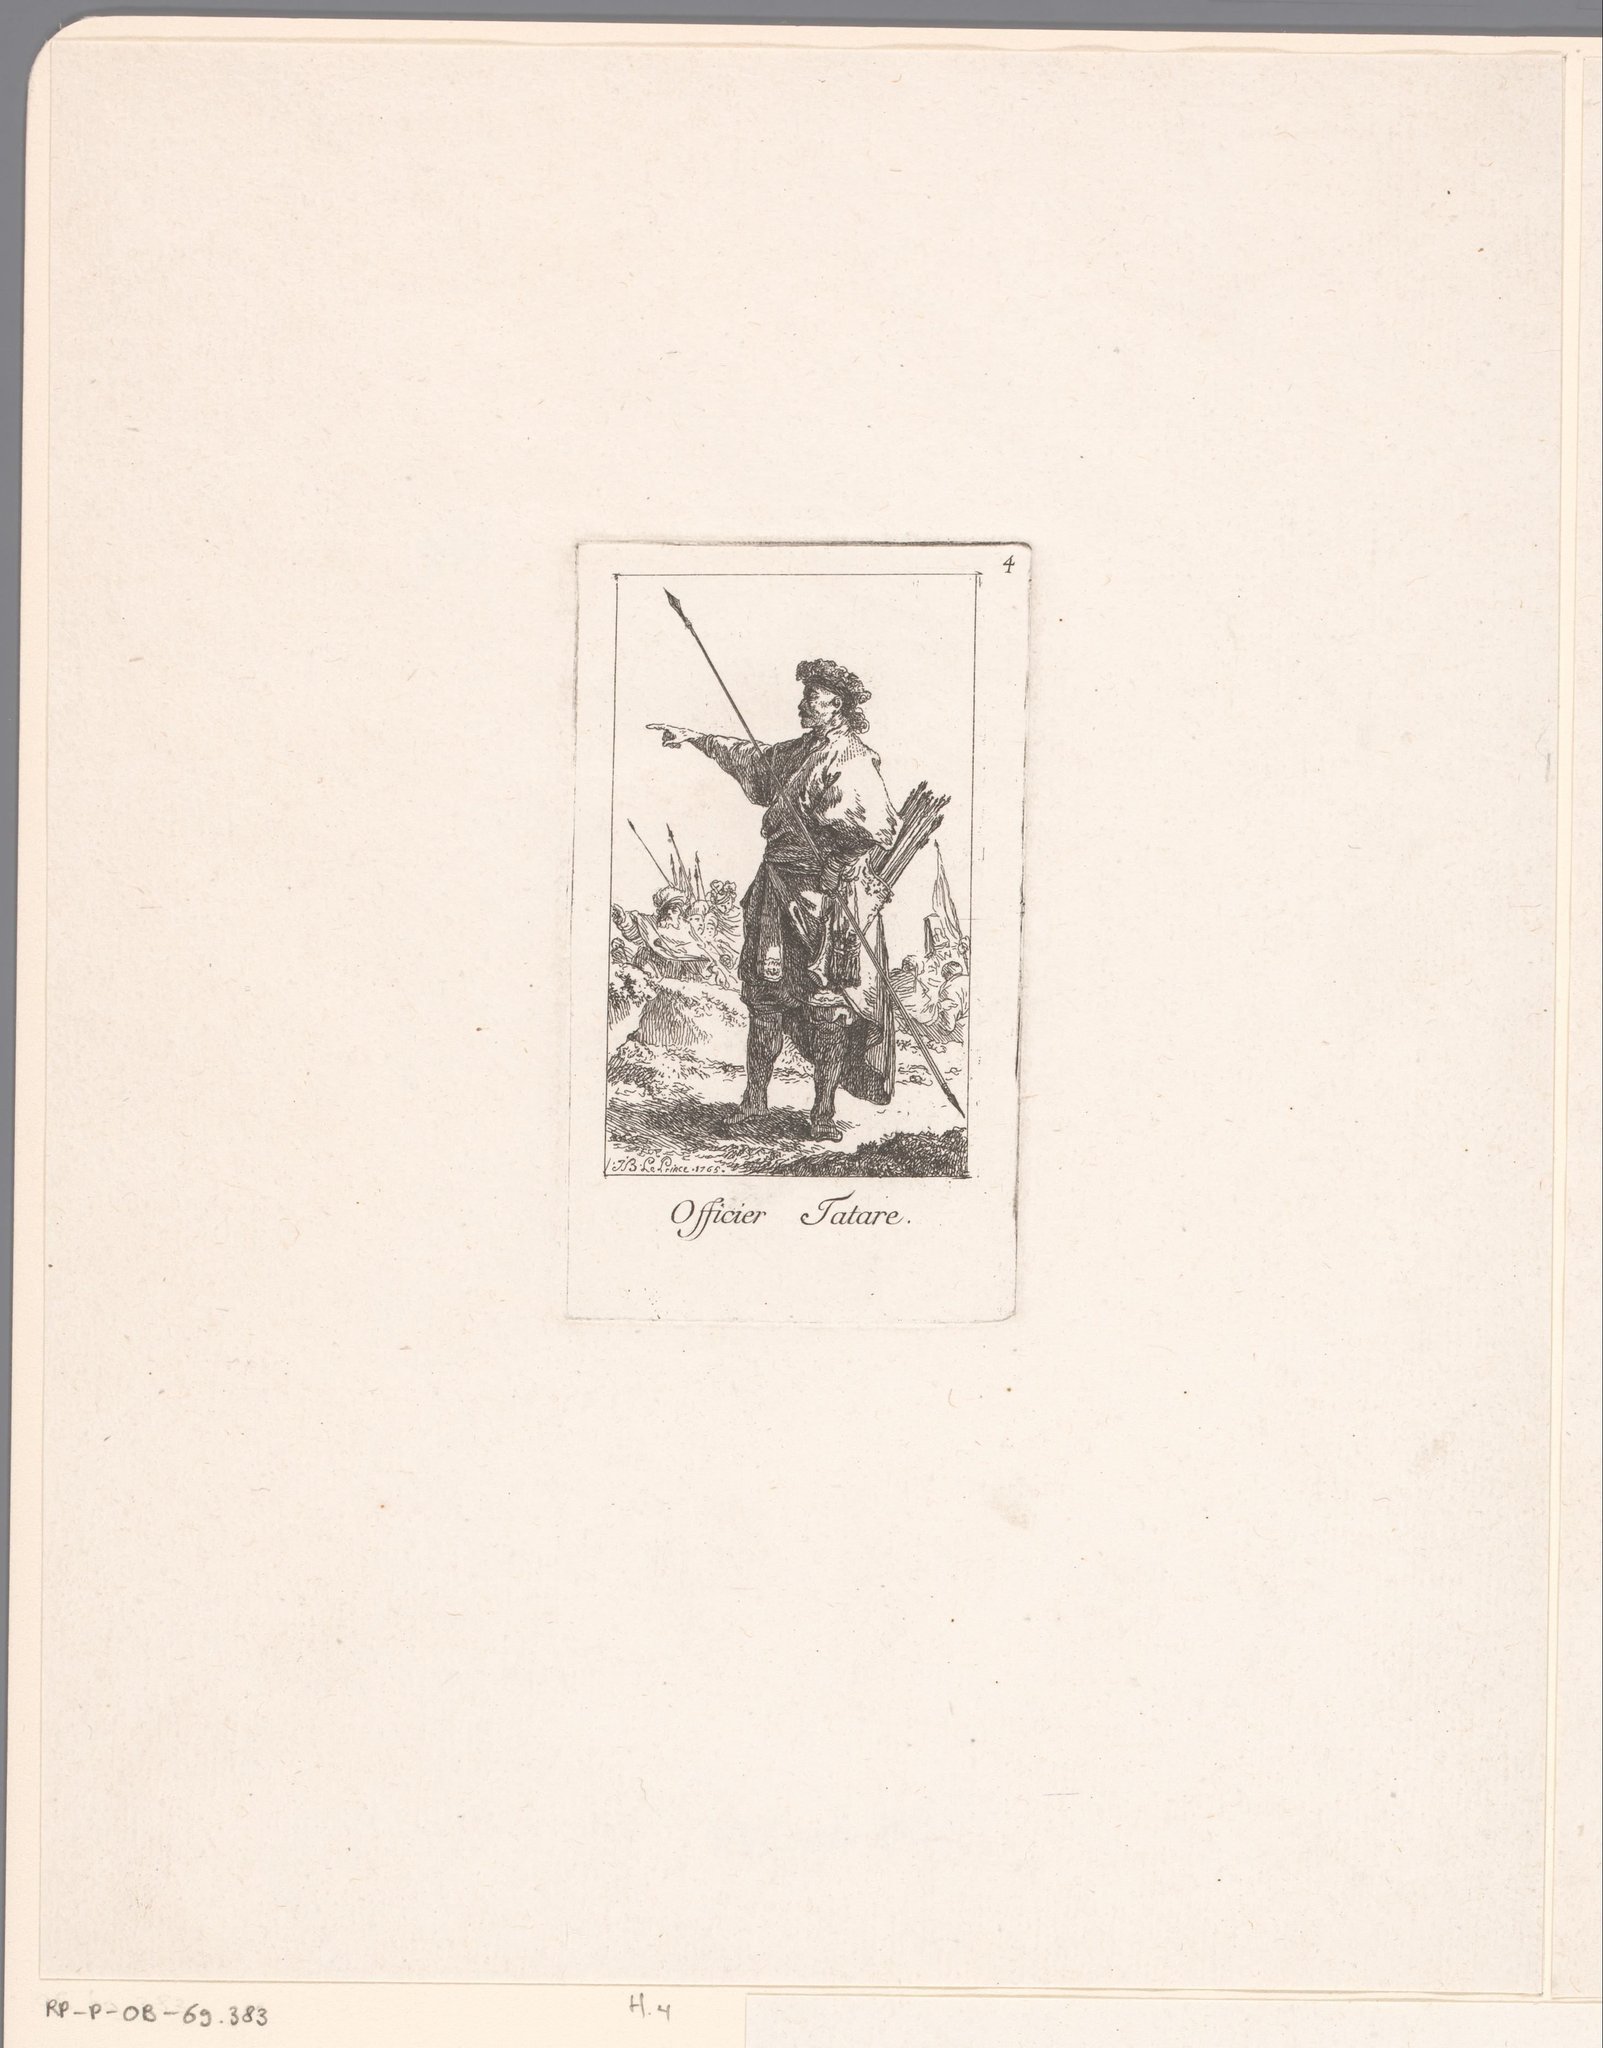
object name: print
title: Tartaarse officier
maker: jean baptist leprince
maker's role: draughtsman, print maker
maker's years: 1734-1781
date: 1765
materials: paper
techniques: etching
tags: folk costume, regional costume, asiatic races and peoples (tatars)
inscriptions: date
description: Maakt deel uit van een zesdelige serie met figuren in kostuums van verschillende nationaliteiten.